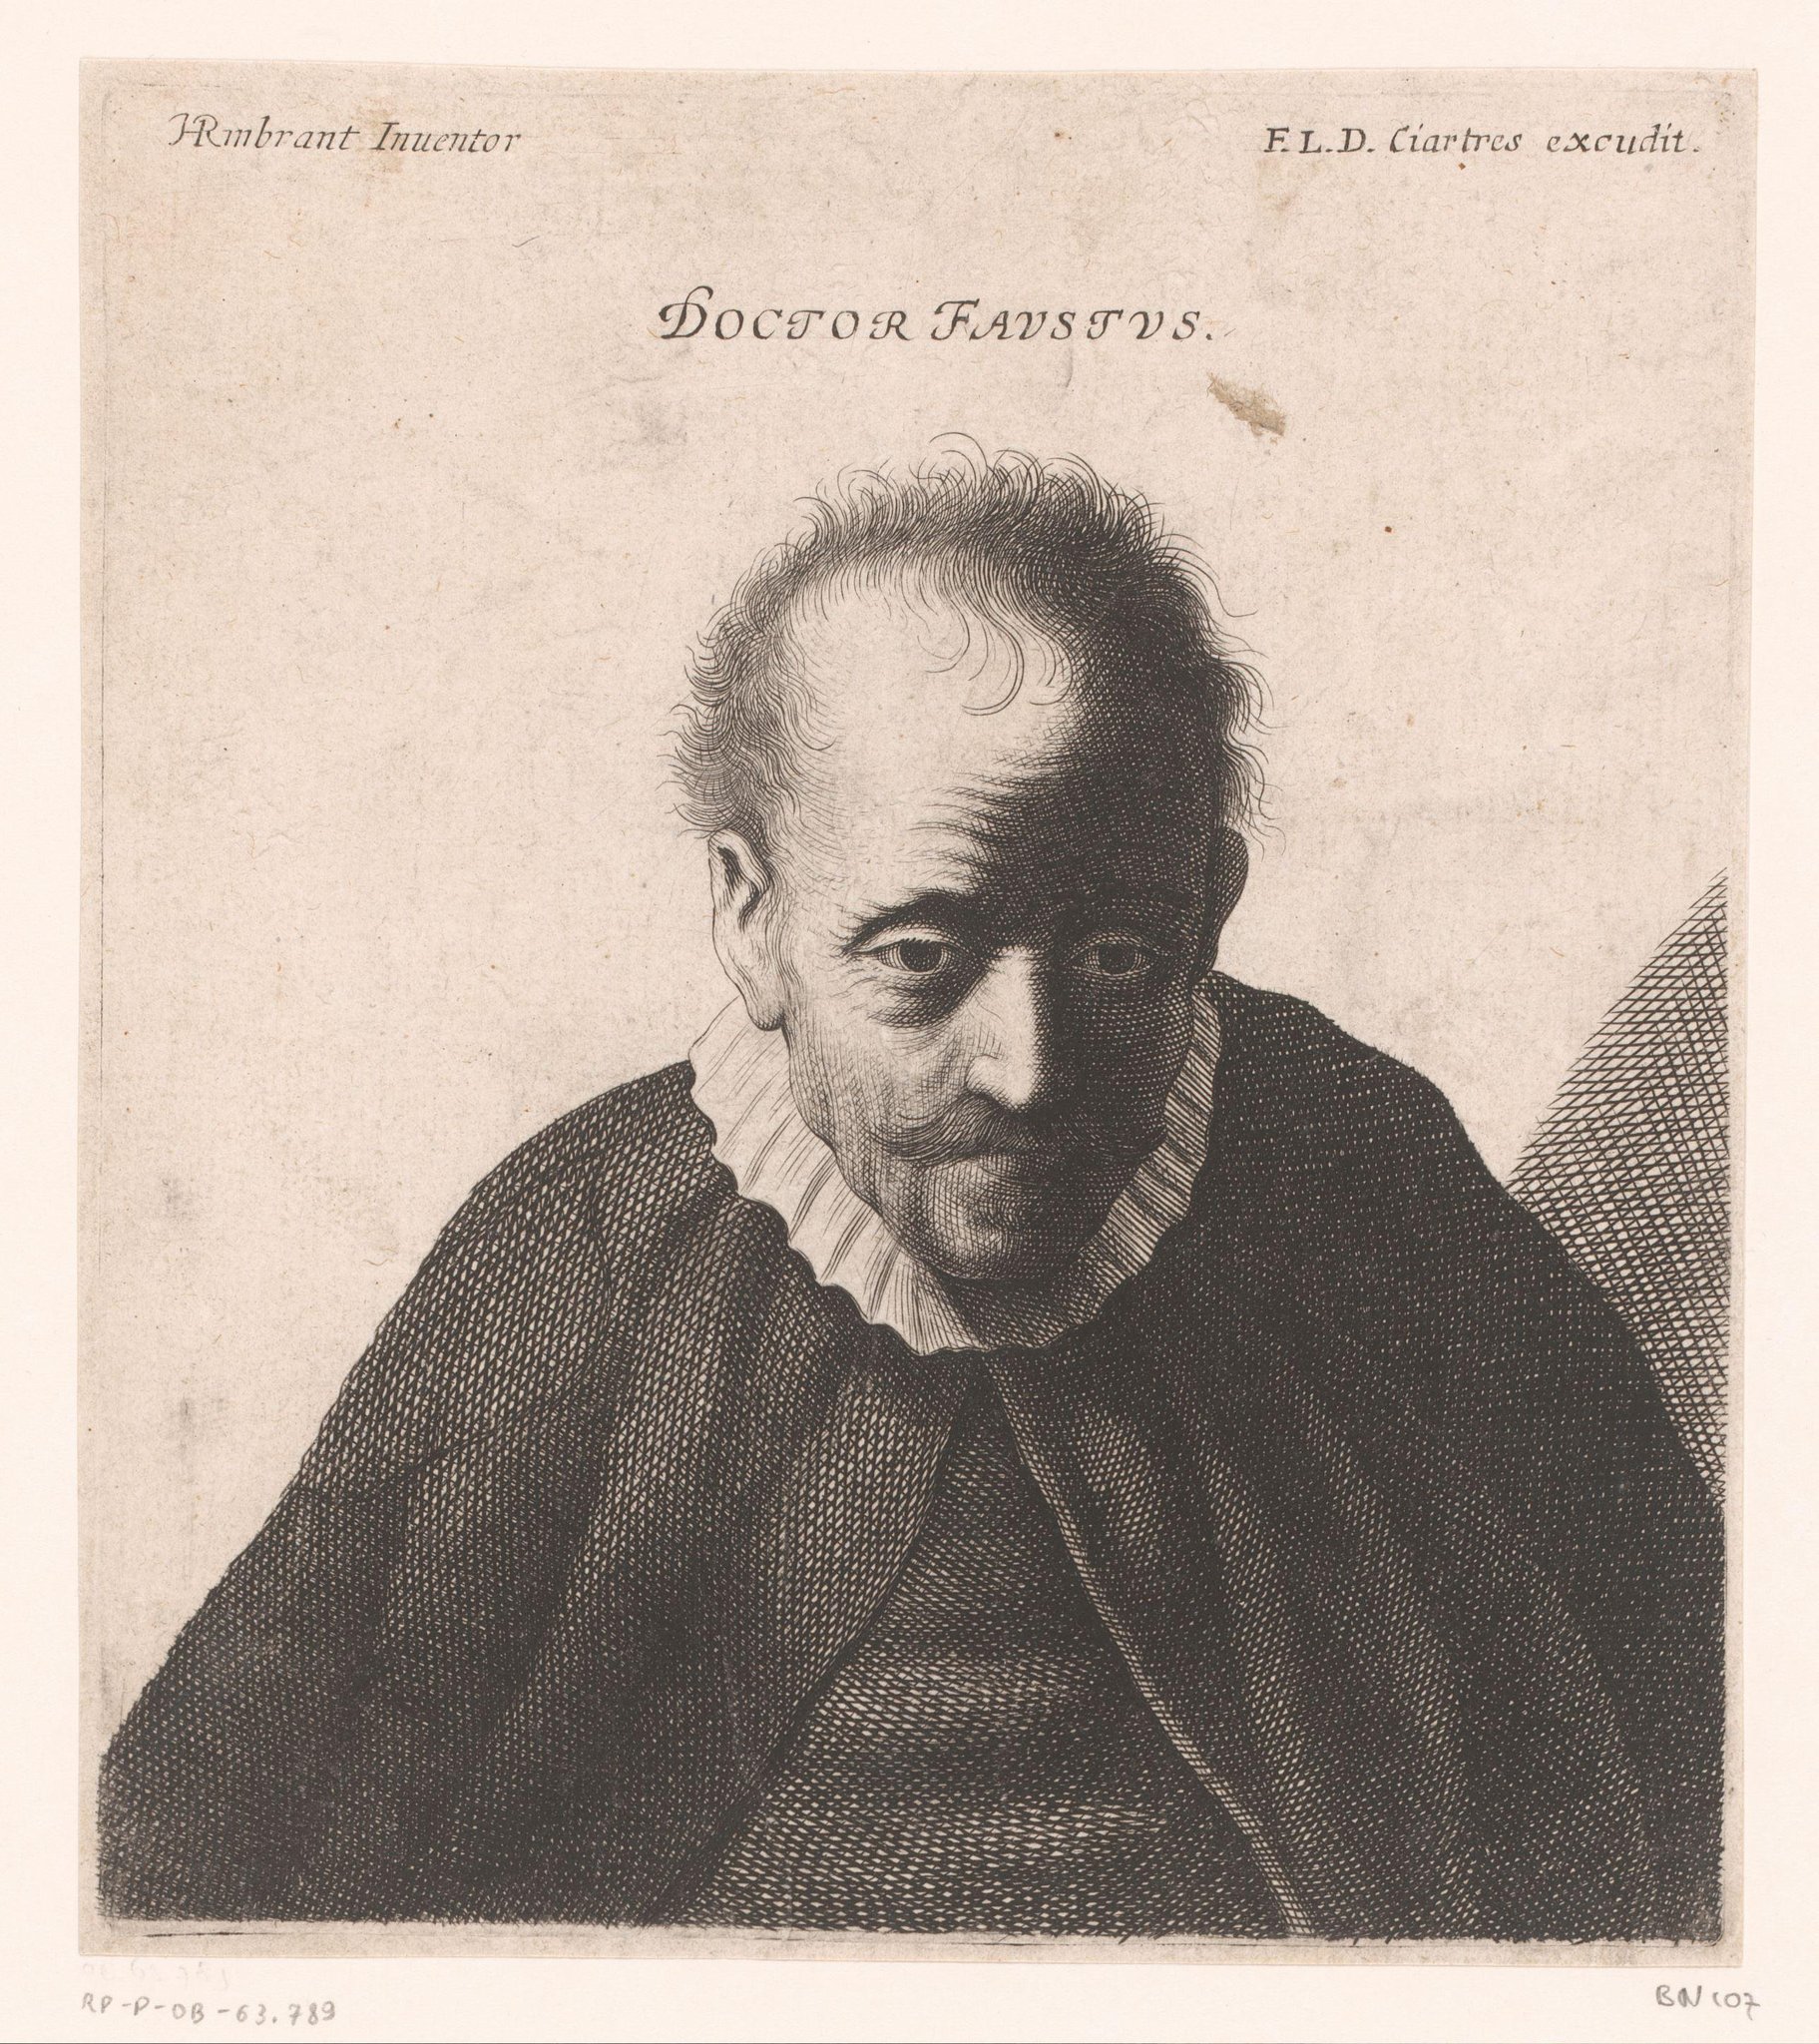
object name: print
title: Doctor Faustus.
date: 1615-1647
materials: paper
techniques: engraving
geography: paris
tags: theatre, theatrical performance, faust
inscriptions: collector's mark: Lugt 2228